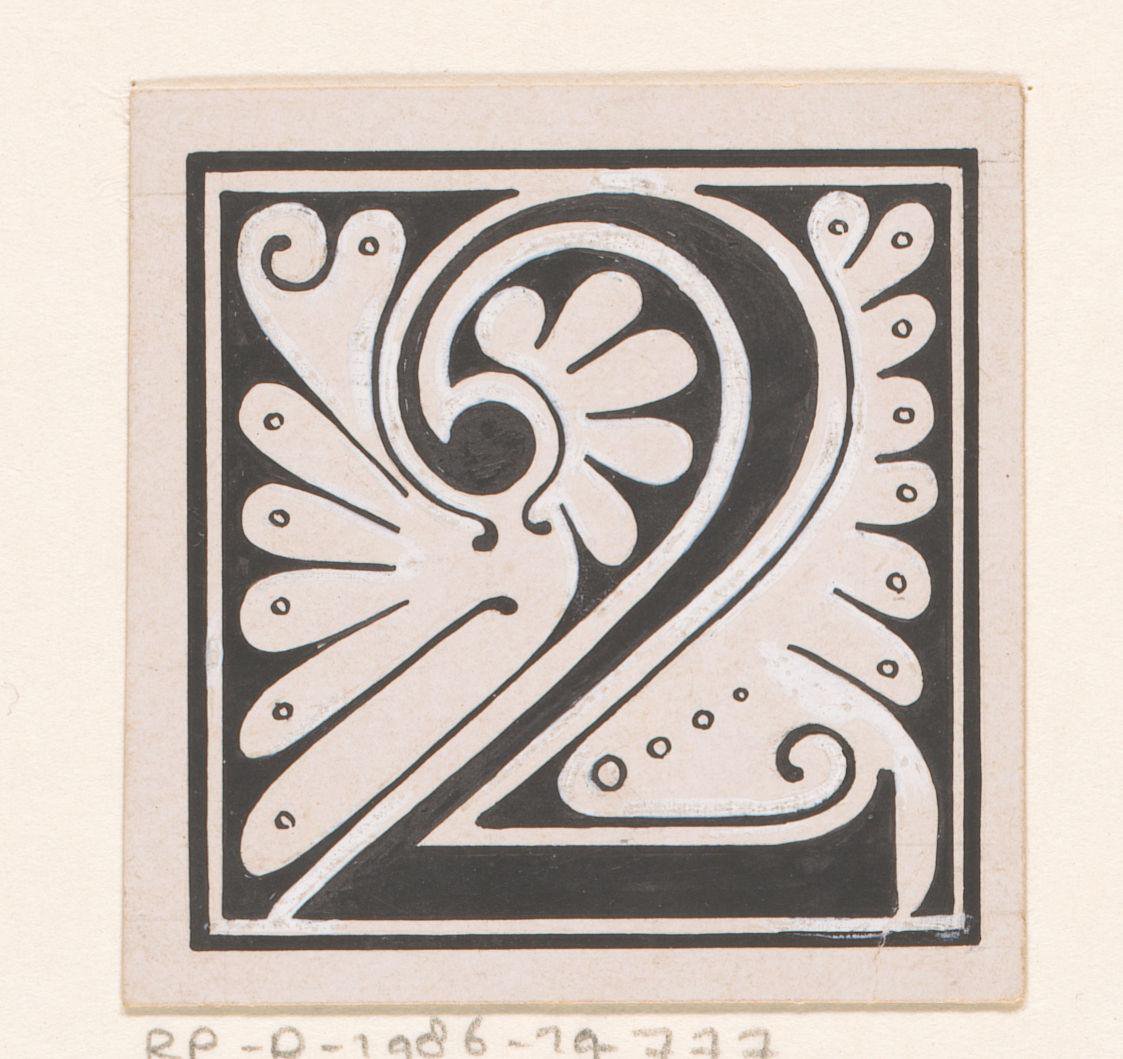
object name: design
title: Getal 2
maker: reinier willem petrus de vries (1874-1953)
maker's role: draughtsman, print maker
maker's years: 1874-1953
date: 1904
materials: paint, ink, paper, pencil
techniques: brush, pen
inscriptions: collector's mark: ‘R:MVS.’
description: Het getal is gebruikt voor: Veth, Jan. Jozef Israëls en zijn kunst. Arnhem en Nijmegen: Gebroeders E&M Cohen, 1904.